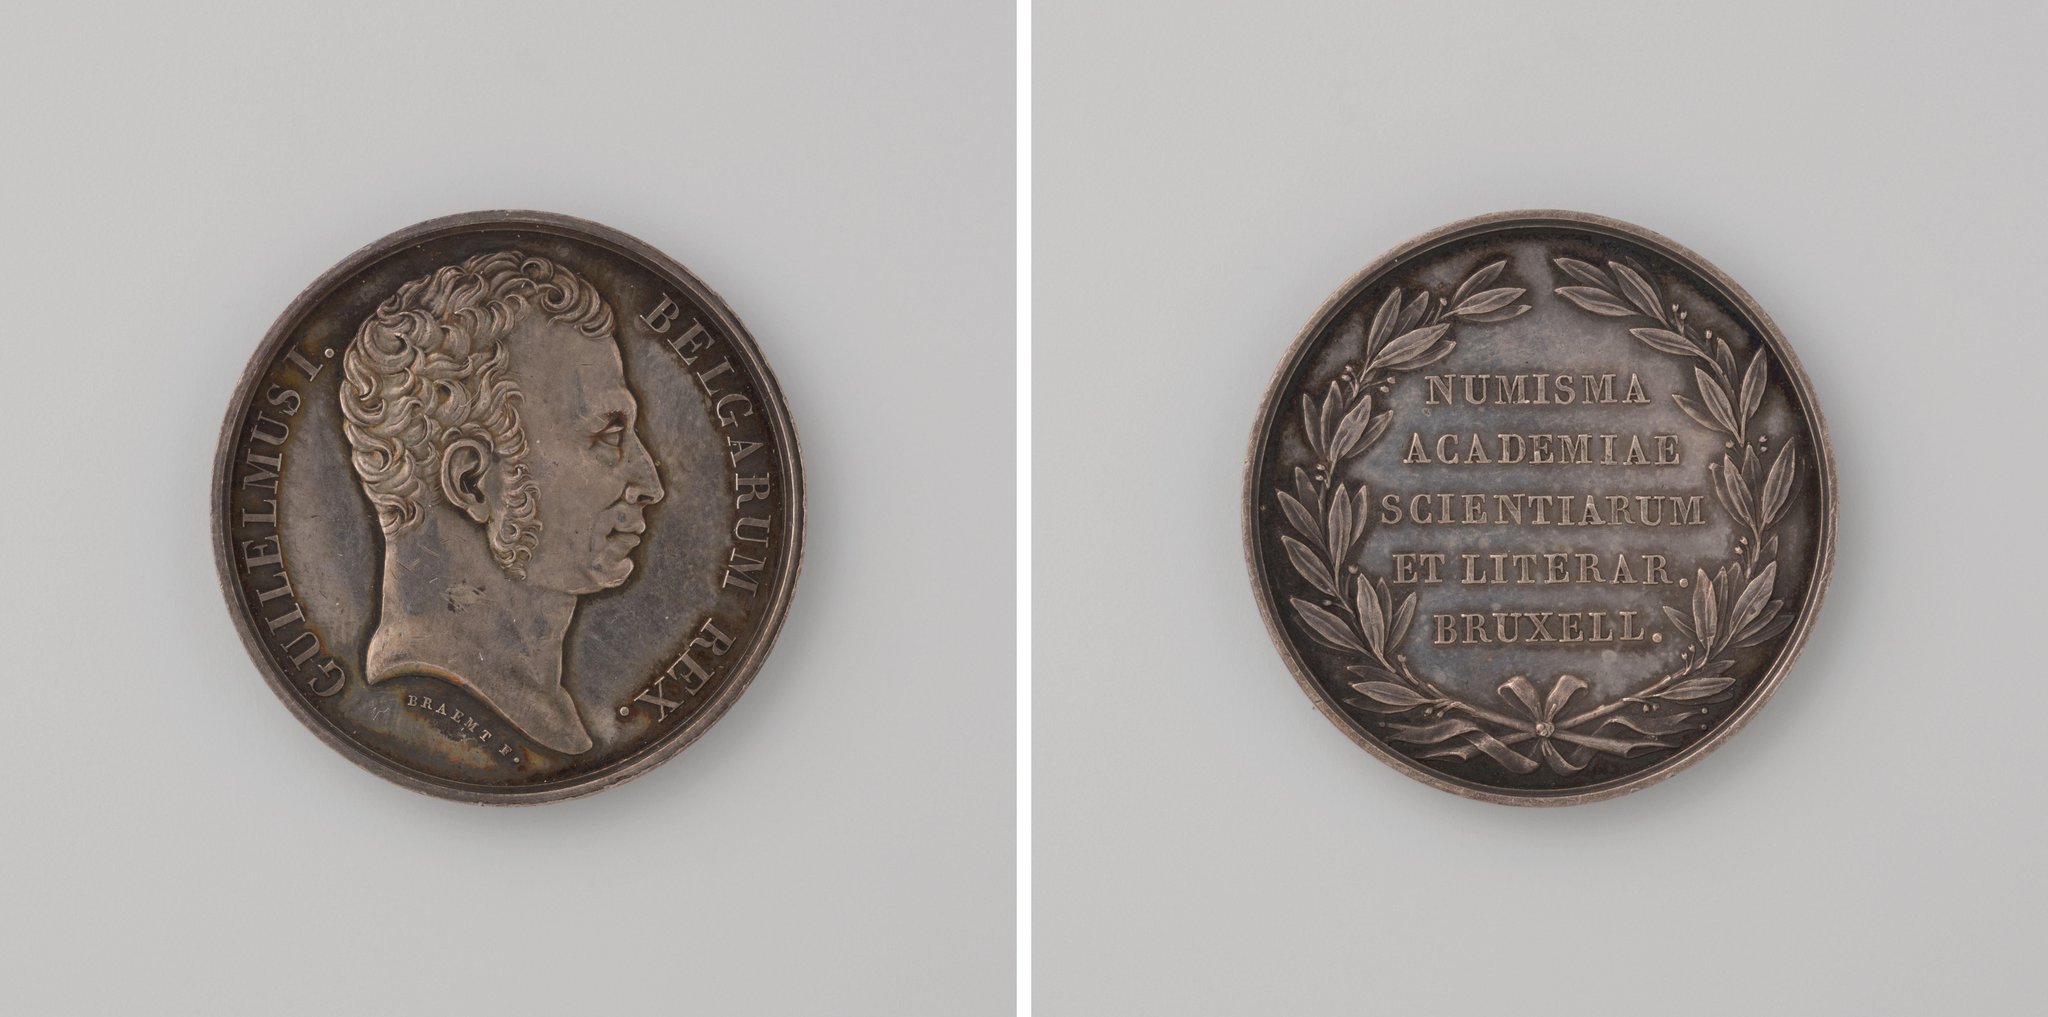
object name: medal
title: Koninklijke Academie van Wetenschappen en Letteren te Brussel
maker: joseph pierre braemt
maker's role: print maker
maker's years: 1796-1864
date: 1816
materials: silver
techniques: striking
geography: brussels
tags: william i of the netherlands, brussels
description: Zilveren penning. Voorzijde: borststuk man binnen omschrift. Keerzijde: opschrift binnen krans van olijftakken